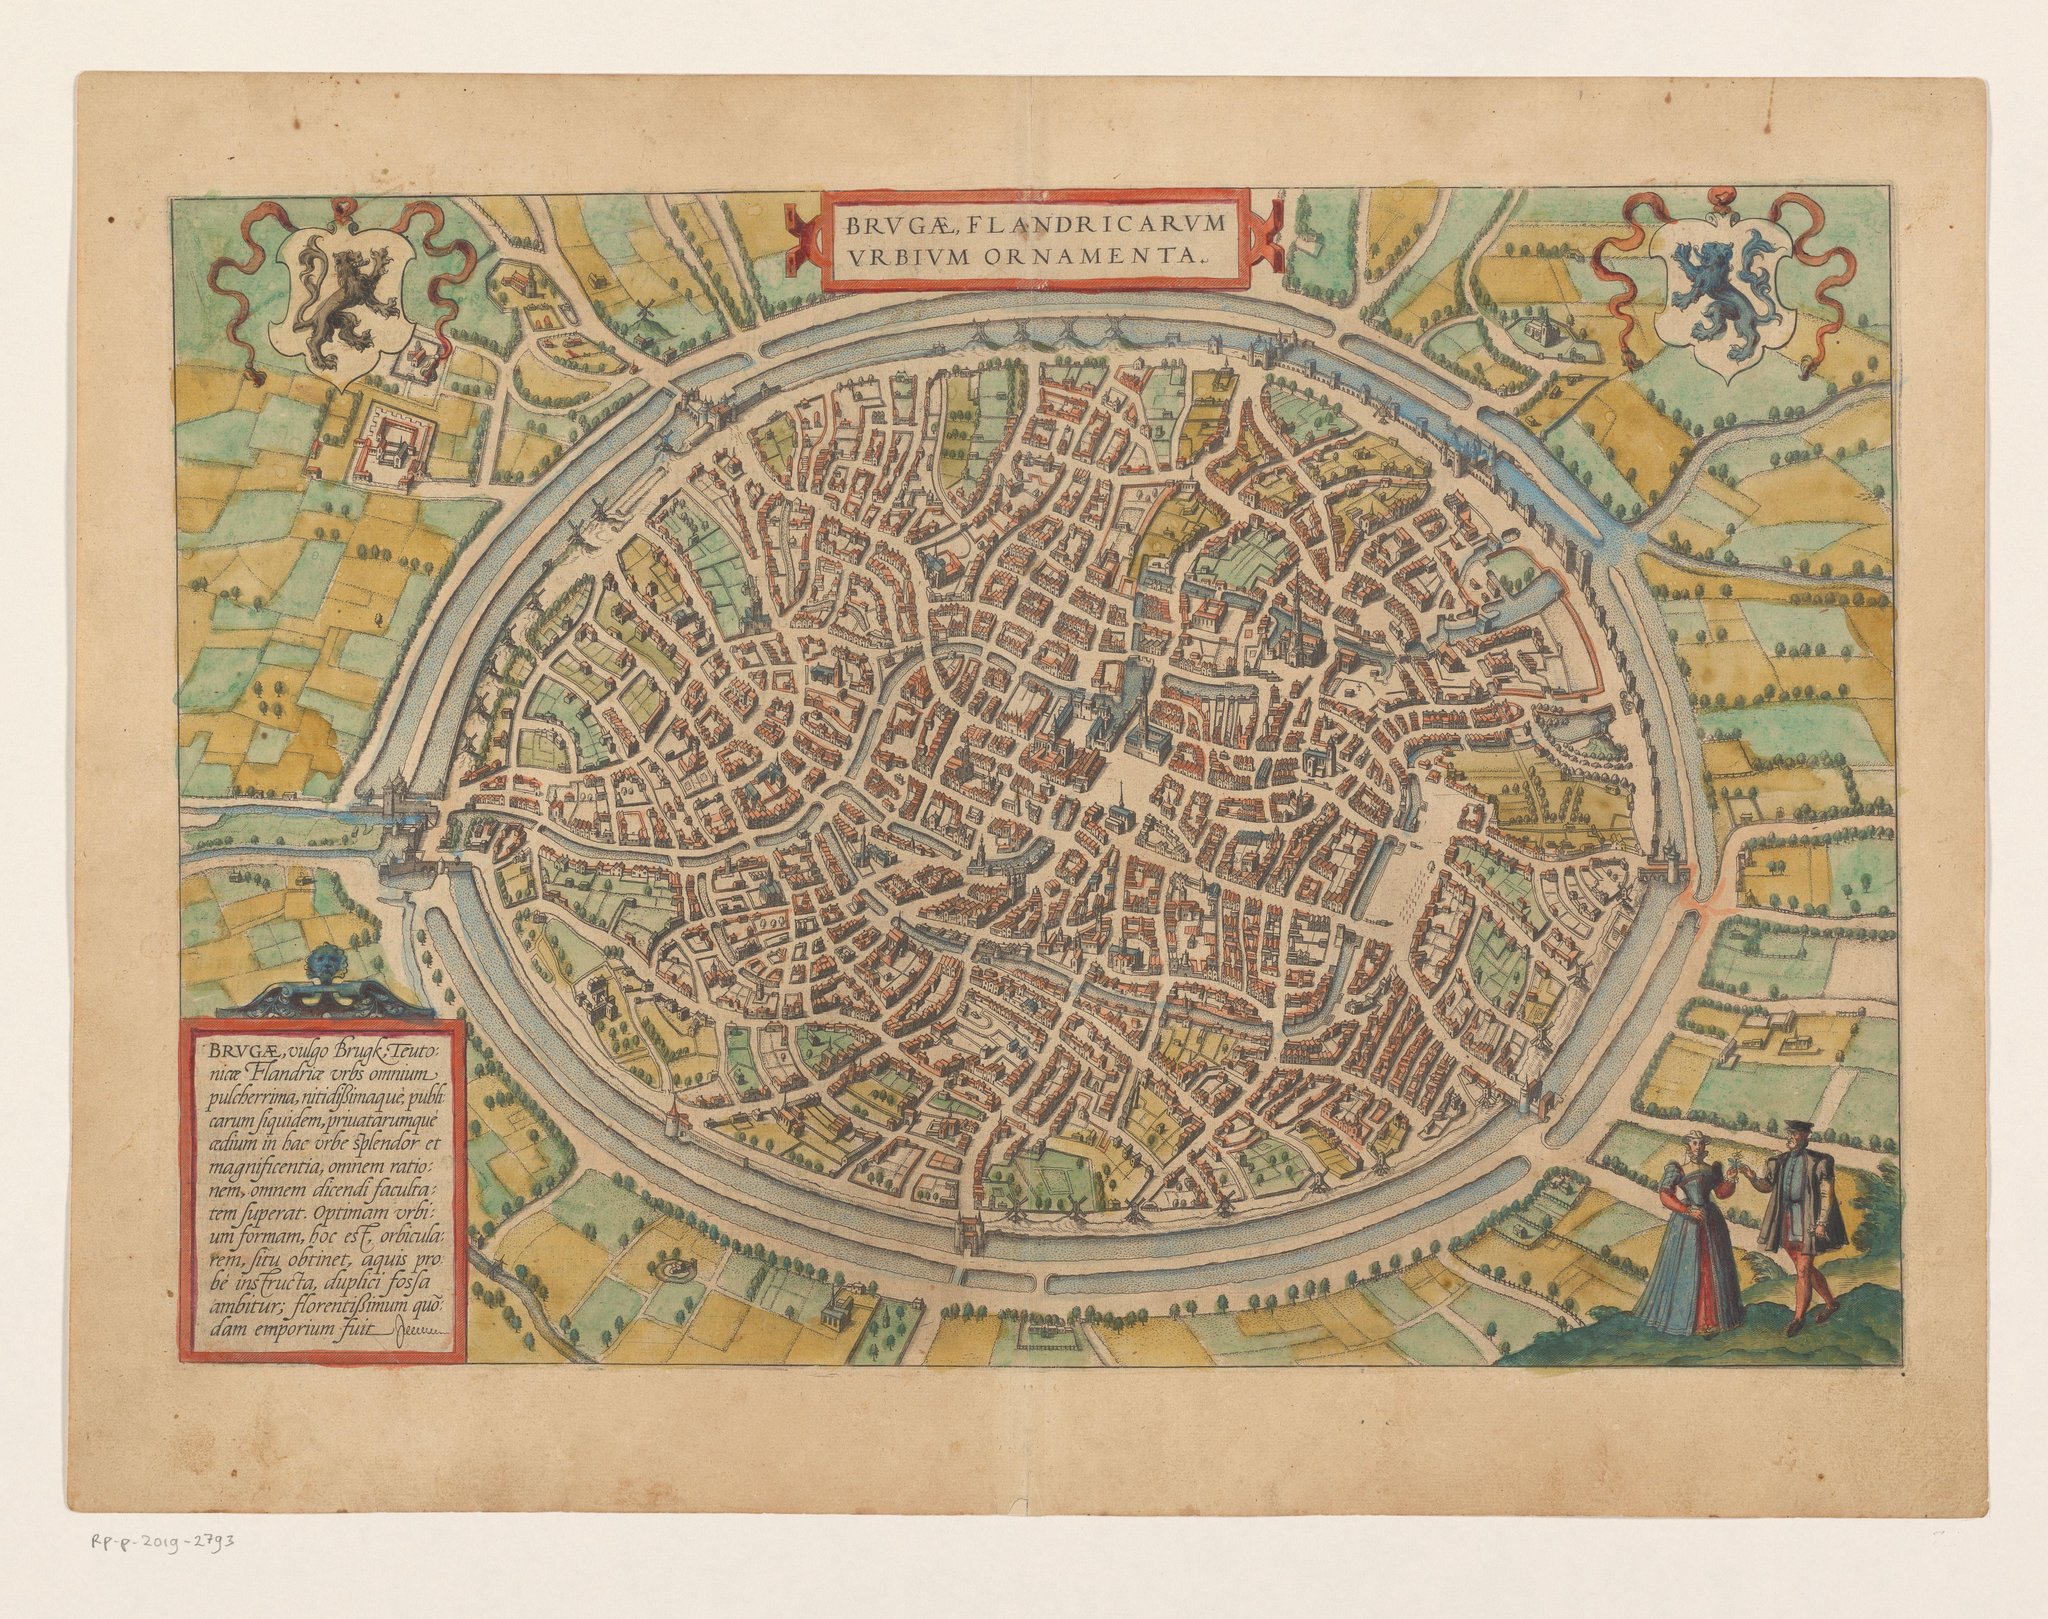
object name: print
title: Plattegrond van Brugge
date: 1574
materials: paper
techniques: etching, hand coloring, letterpress printing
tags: maps of cities, bruges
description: Prent uit: Beschreibung und Contrafactur de vornembster Stät der Welt. 6 dln. S.l.: Braun en Hogenberg, 1574-1618.